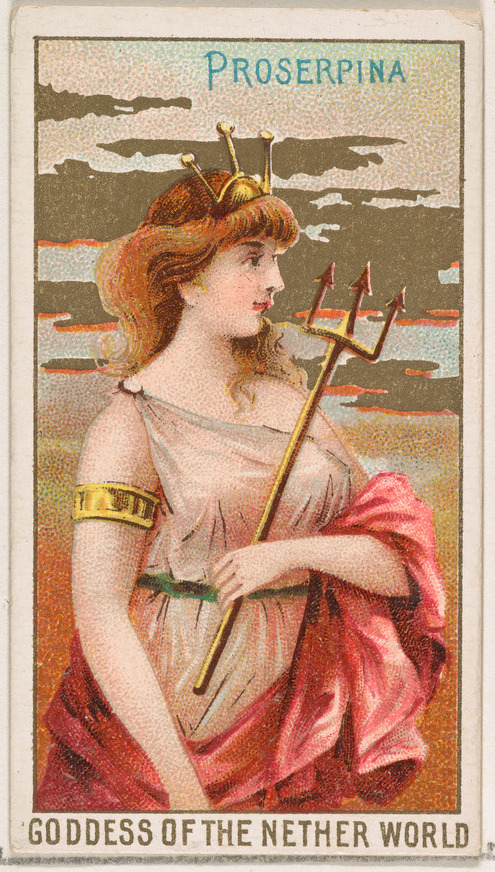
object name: print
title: Proserpina, Goddess of the Nether World, from the Goddesses of the Greeks and Romans series (N188) issued by Wm. S. Kimball & Co.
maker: william s. kimball & company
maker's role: publisher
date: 1889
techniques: color lithograph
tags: profiles,goddess